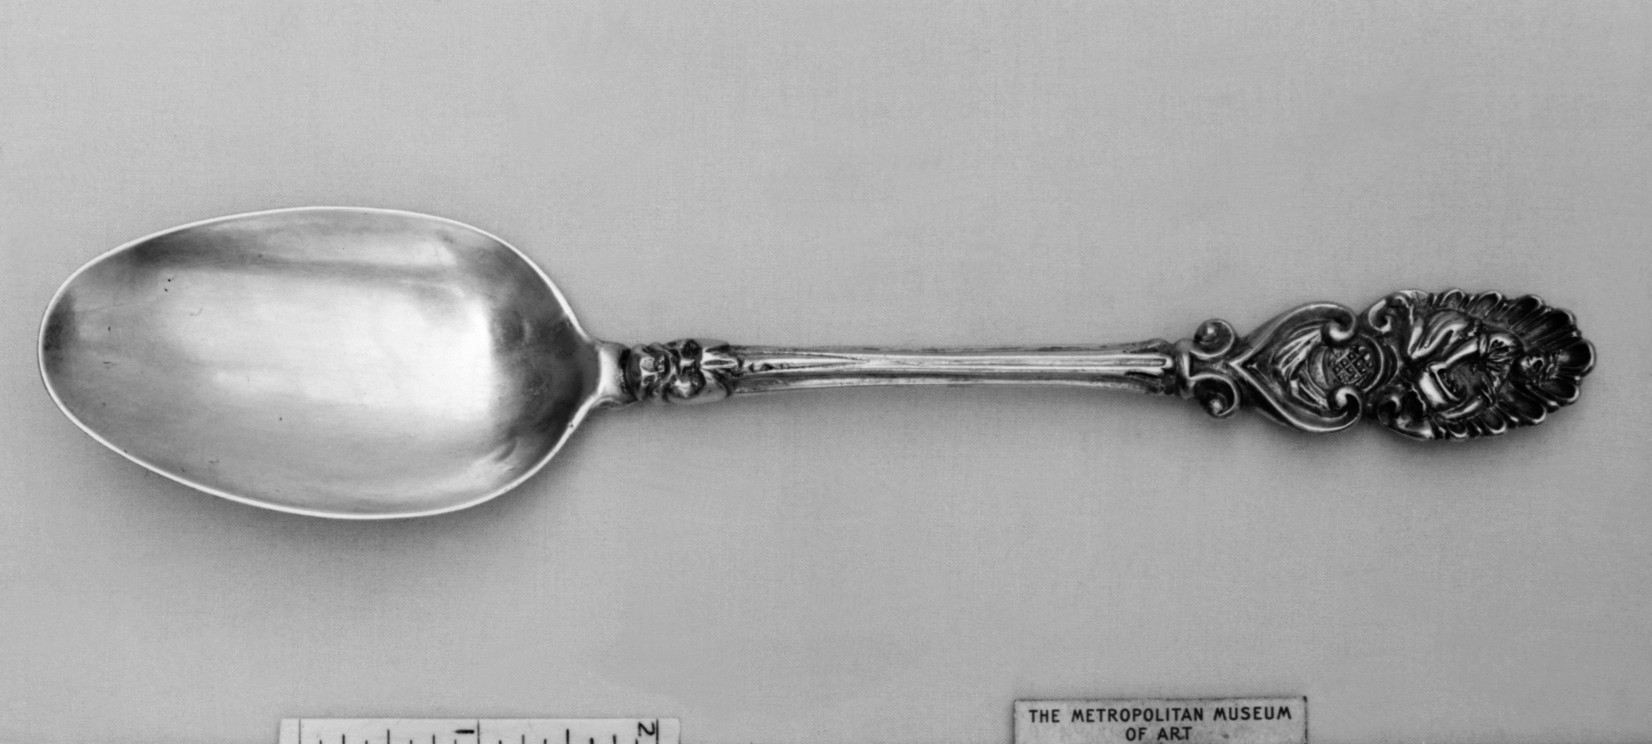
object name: tablespoon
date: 1701-1733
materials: silver gilt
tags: women